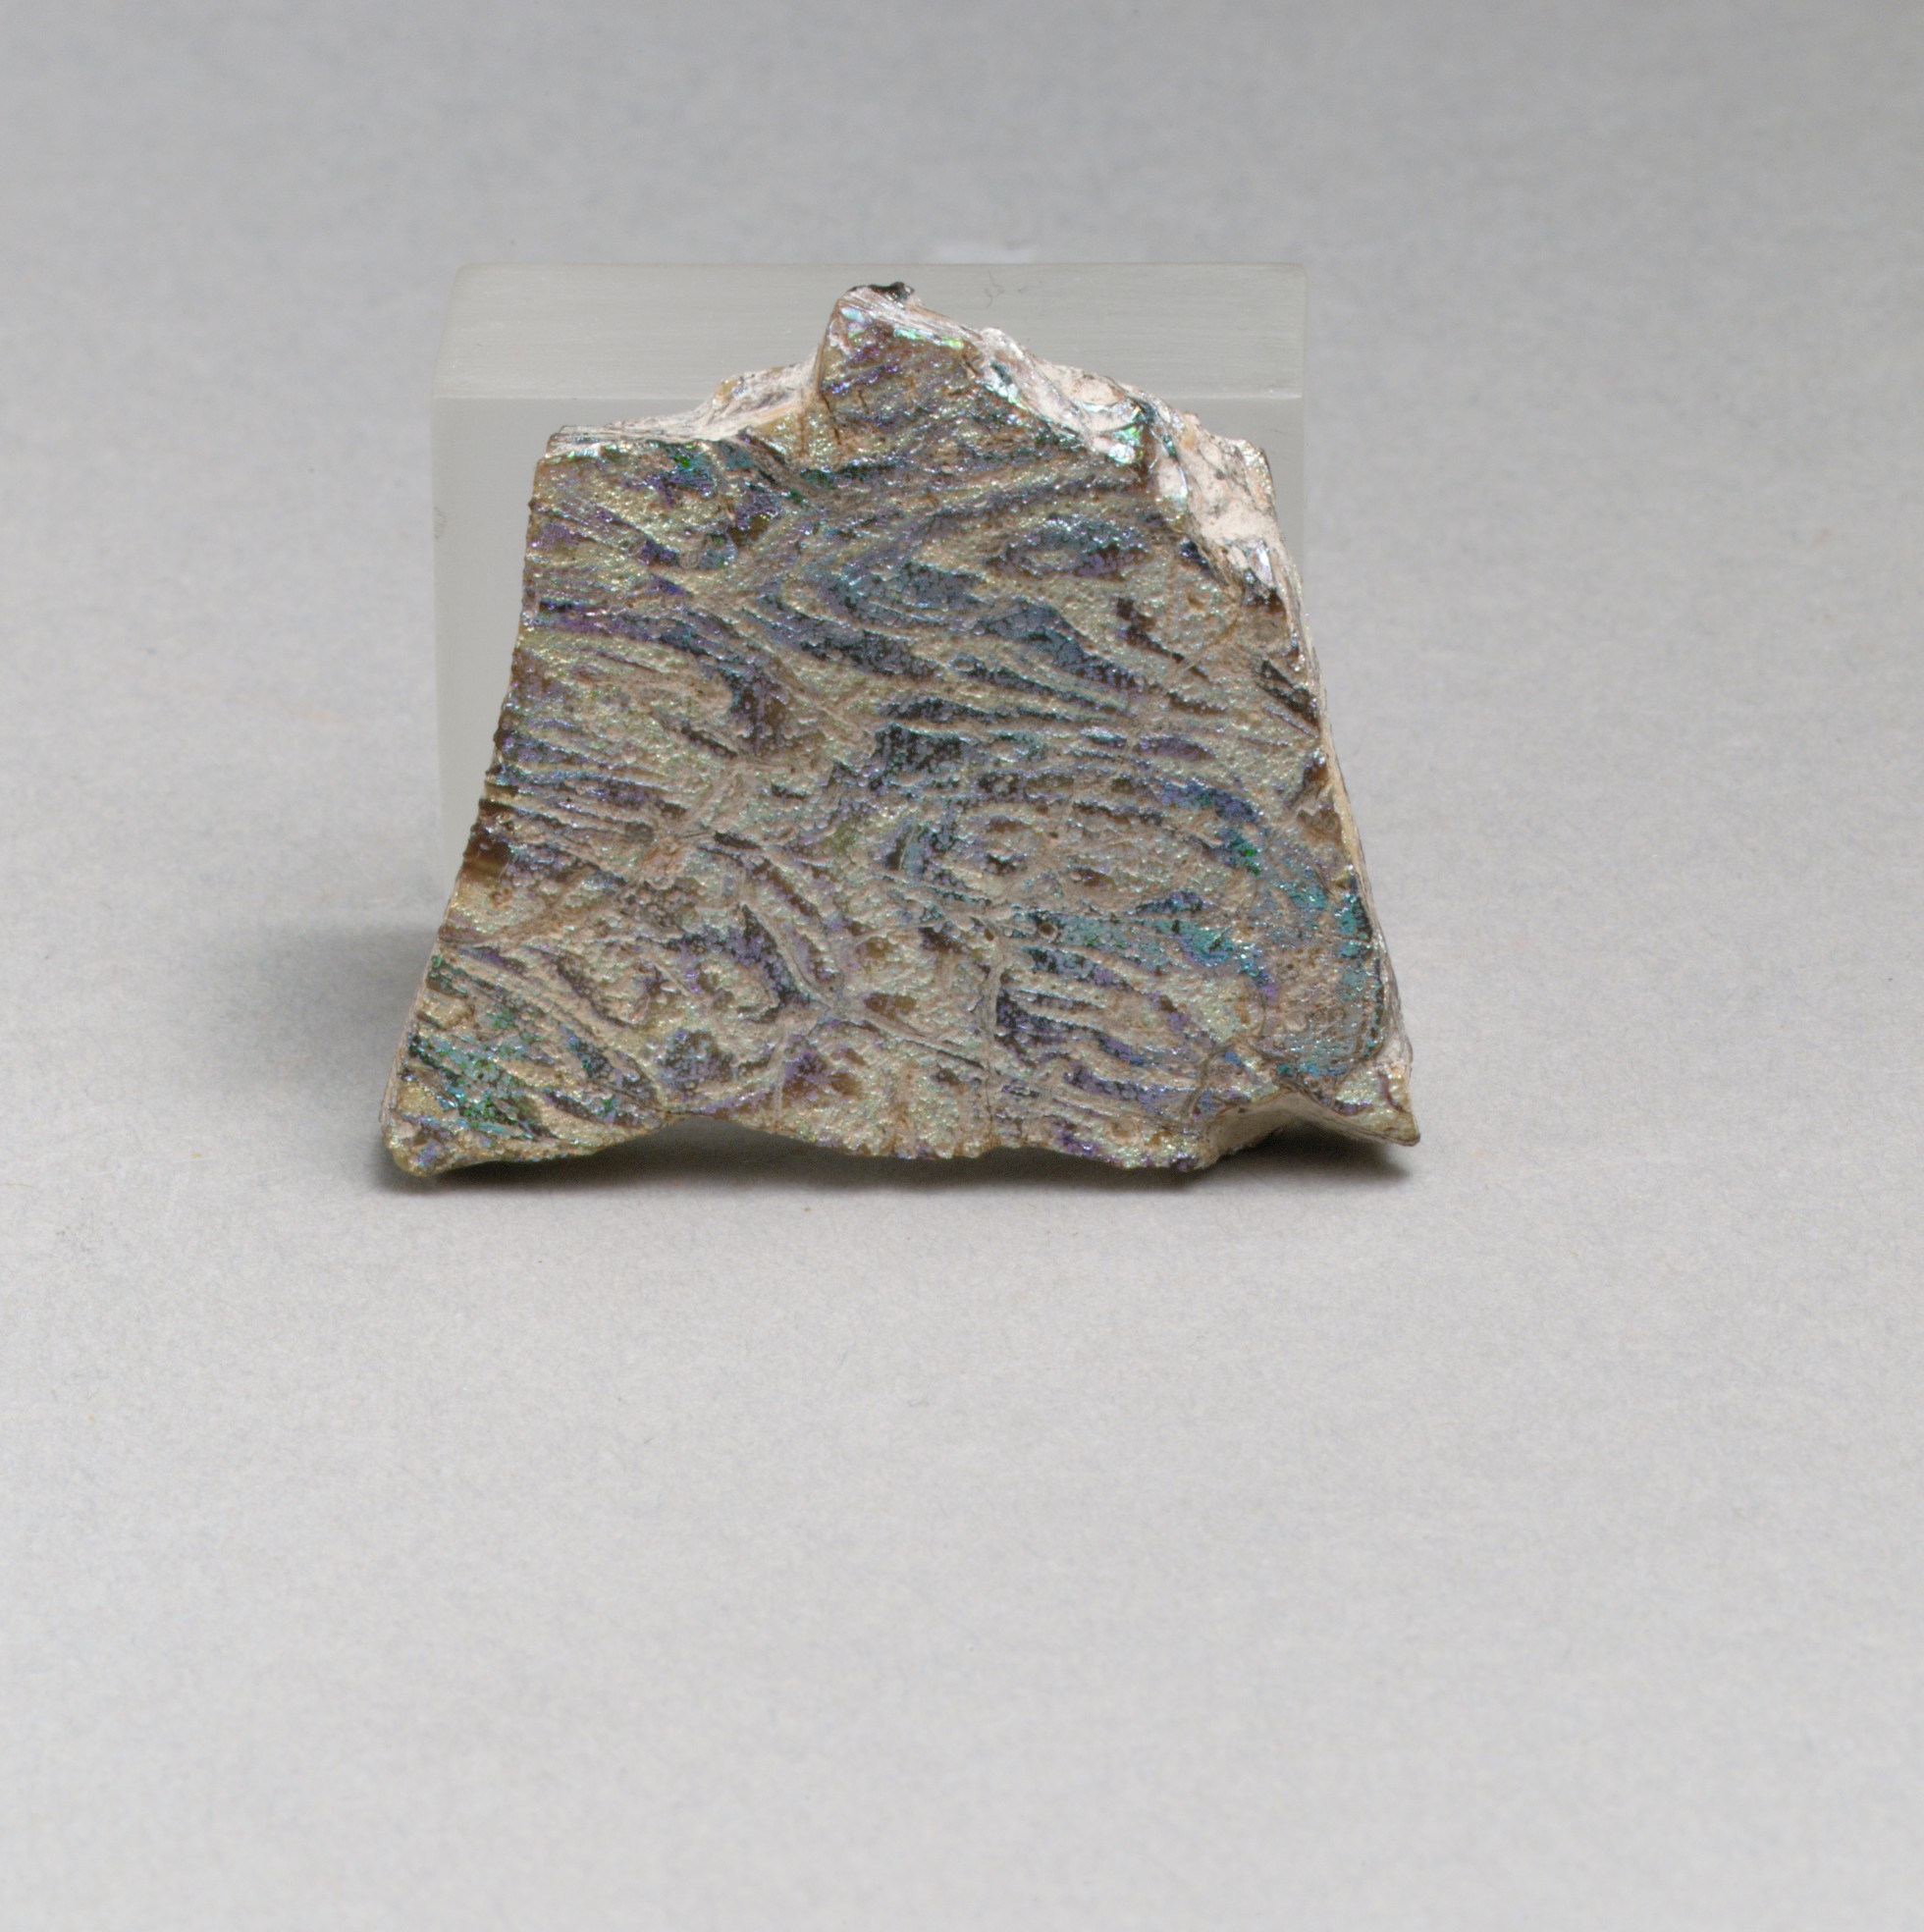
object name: mosaic glass fragment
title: Mosaic glass inlay fragment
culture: roman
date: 1-50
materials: glass